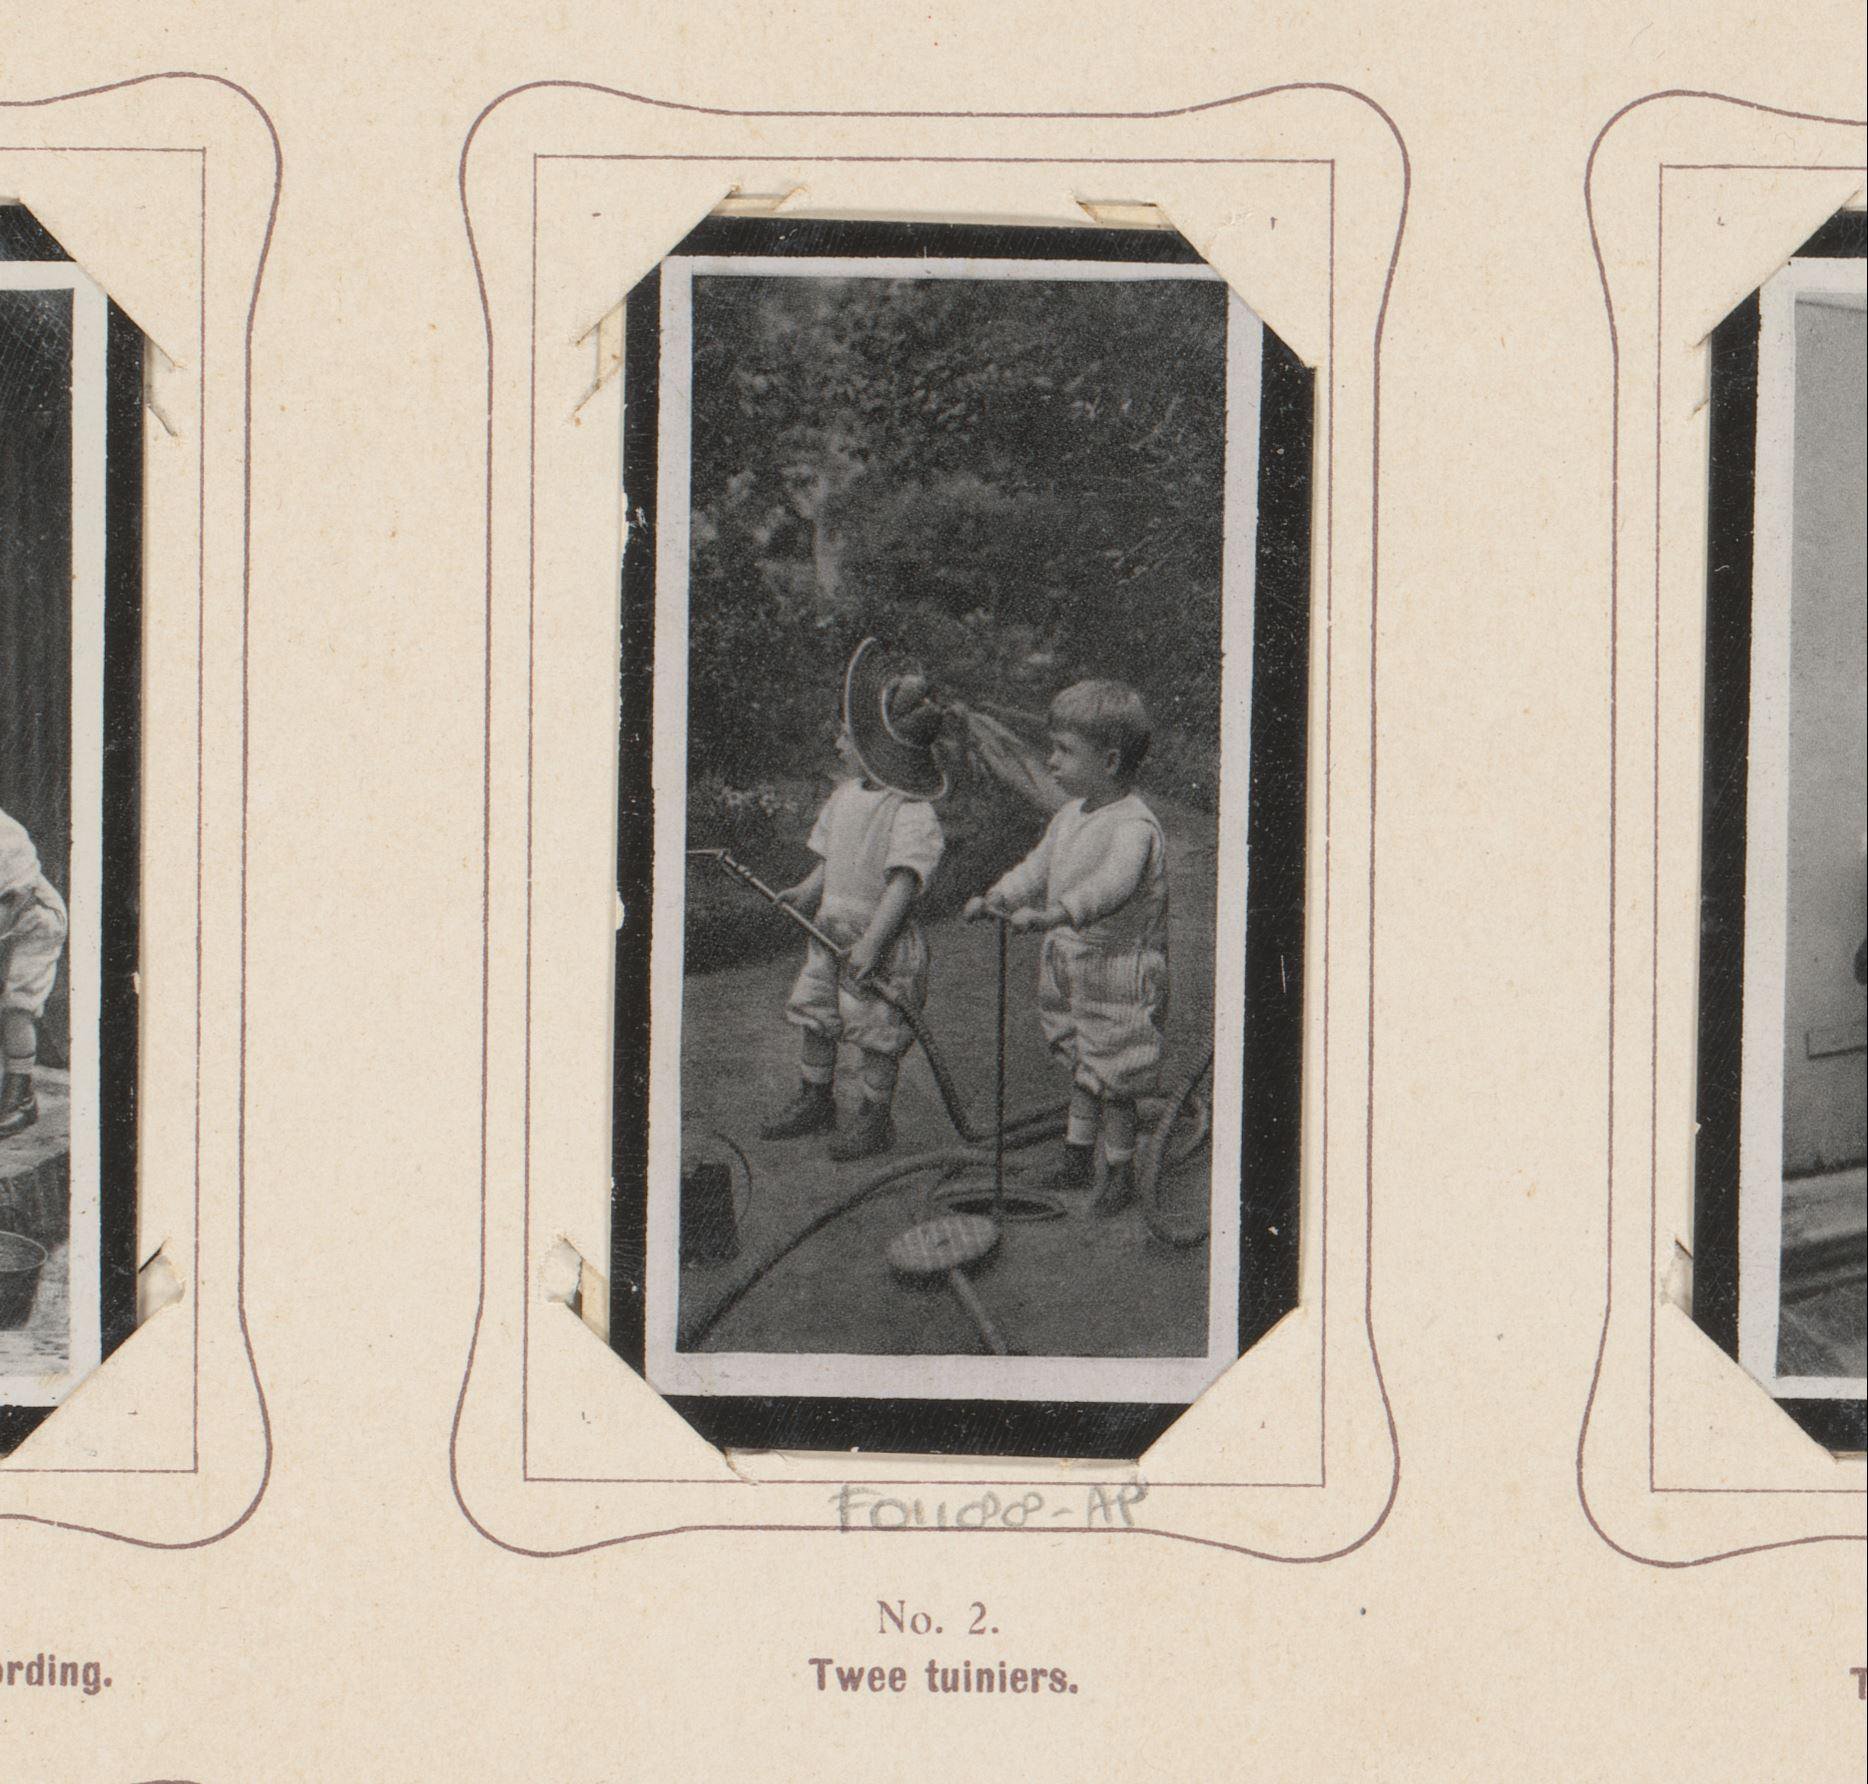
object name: album leaf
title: Twee kinderen spelen in de tuin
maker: Anonymous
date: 1906-1907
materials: paper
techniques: photograph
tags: child, playing toddler; child amusing itself, gardening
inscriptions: inscription: ‘No. 2./ Twee tuiniers.’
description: Deze prent maakt deel uit van een album.